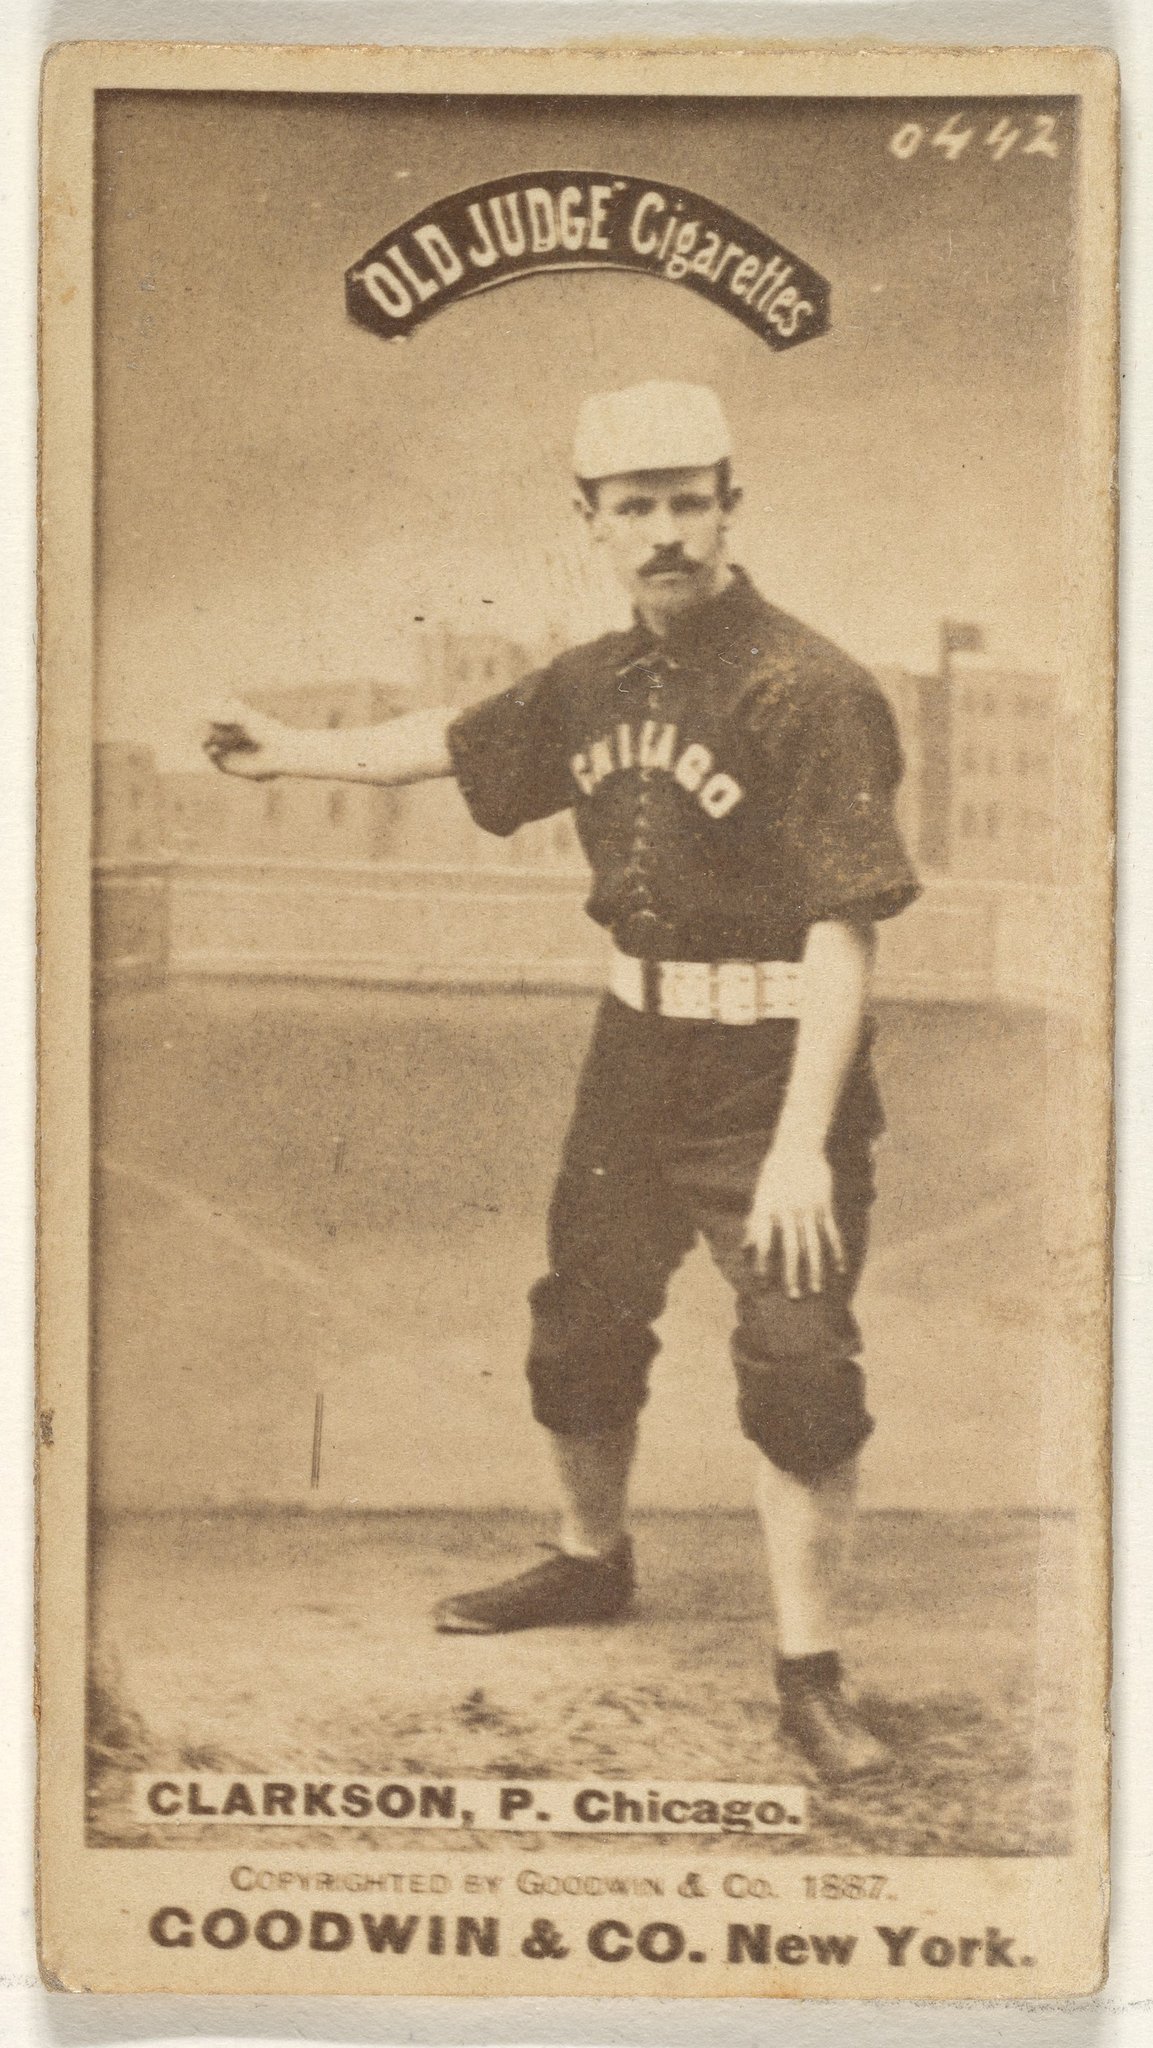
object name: baseball card, photograph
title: Clarkson, Pitcher, Chicago, from the Old Judge series (N172) for Old Judge Cigarettes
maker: goodwin & company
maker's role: publisher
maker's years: 1850-1950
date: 1887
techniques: albumen silver print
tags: men,portraits,baseball,athletes